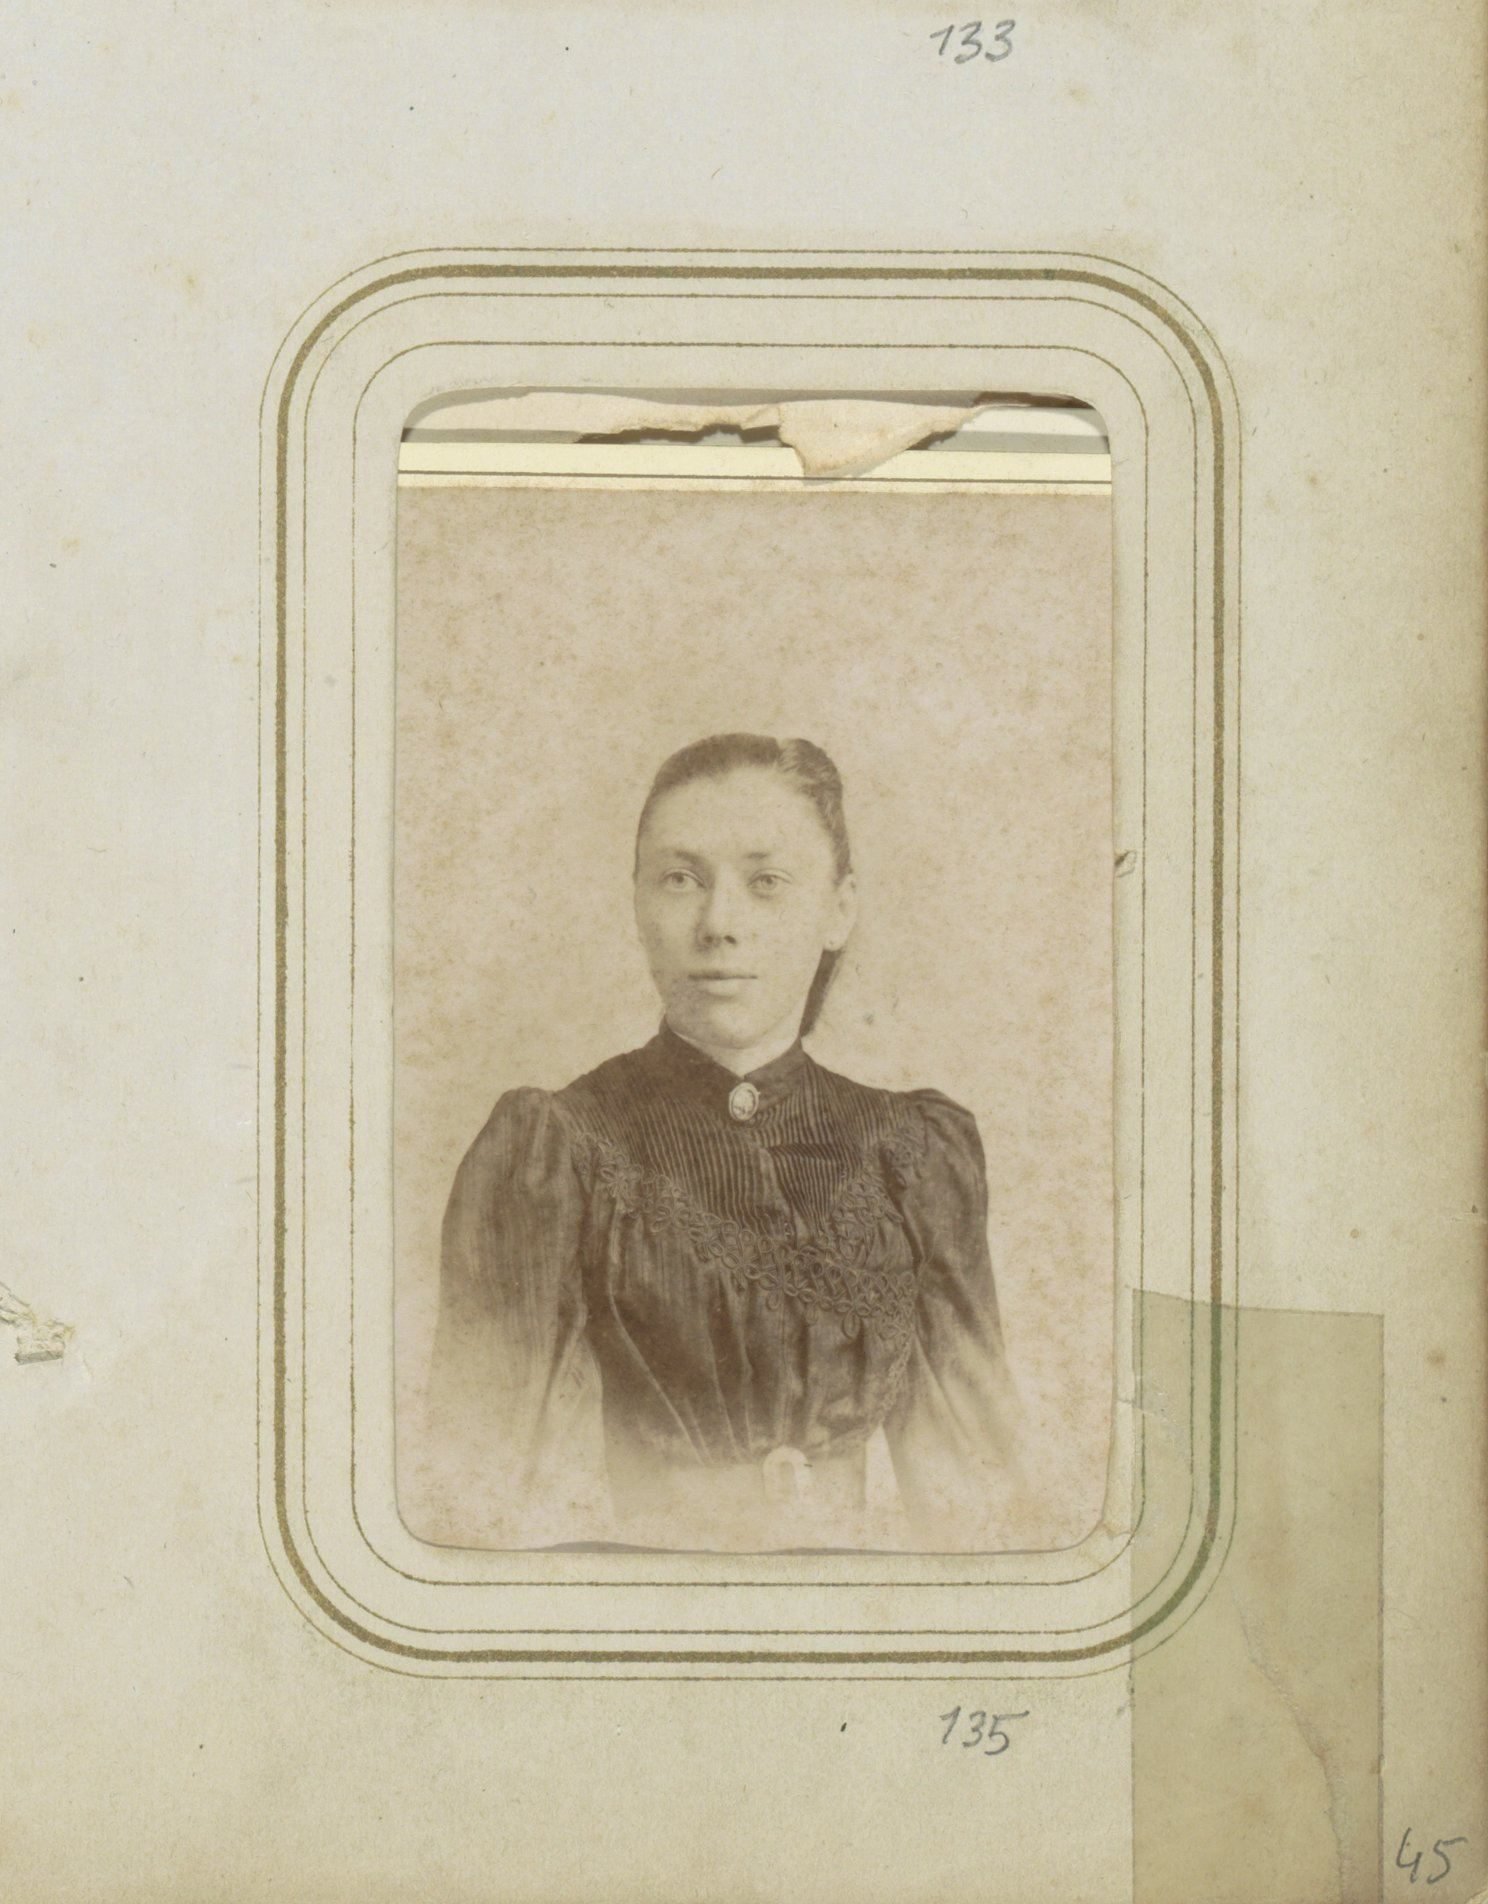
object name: carte de visite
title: Portret van een vrouw in een jurk met een halssieraad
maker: f. meeus-verbeke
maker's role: fotograaf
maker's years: 1845-1906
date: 1875-1899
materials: cardboard, photographic support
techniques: albumen print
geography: leuven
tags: historical persons, styles of hairdress - aa - ~ women, brooch, agraffe, clasp, family, relationship, descent, dress, gown, louvain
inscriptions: inscription: ‘Souvenir affectueux à ma chère Lina. Valentine Bemelmans.’, address: ‘Louvain’, address: ‘24, Rue de la Station Louvain’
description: Onderdeel van Familiealbum van H.W.F. Ligtenberg en L.M. Swart met 149 foto's en cartes-de-visite.